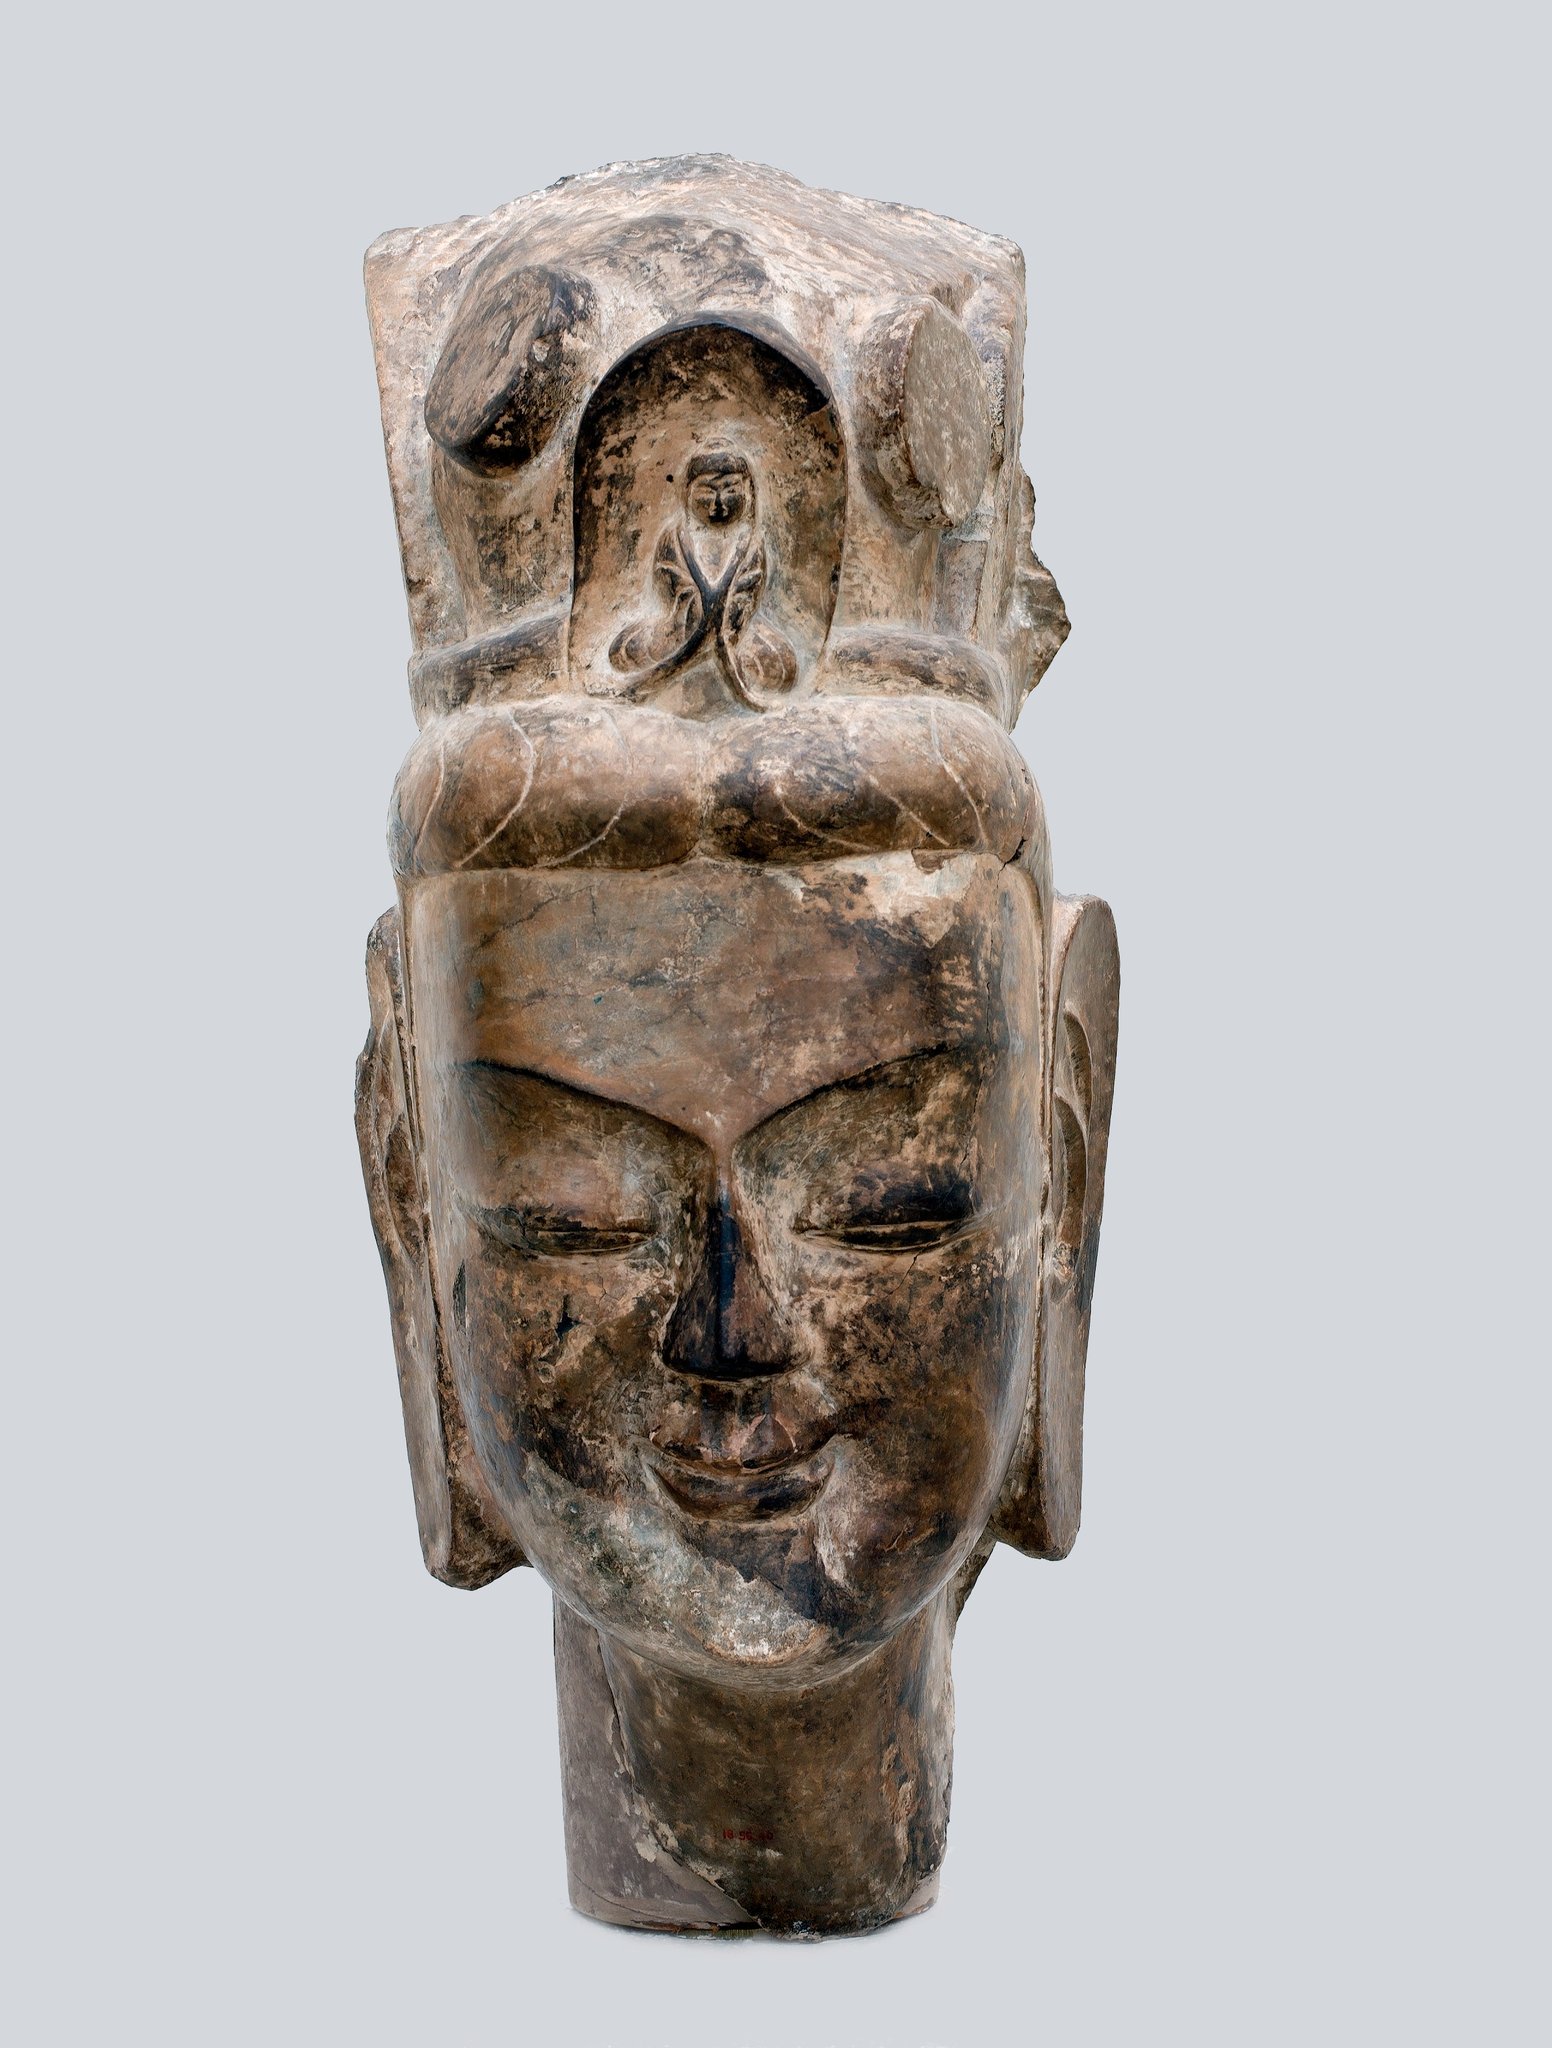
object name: head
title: Head of a bodhisattva, probably Avalokiteshvara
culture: chinese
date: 501-533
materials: limestone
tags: heads,buddhism,avalokiteshvara,bodhisattvas